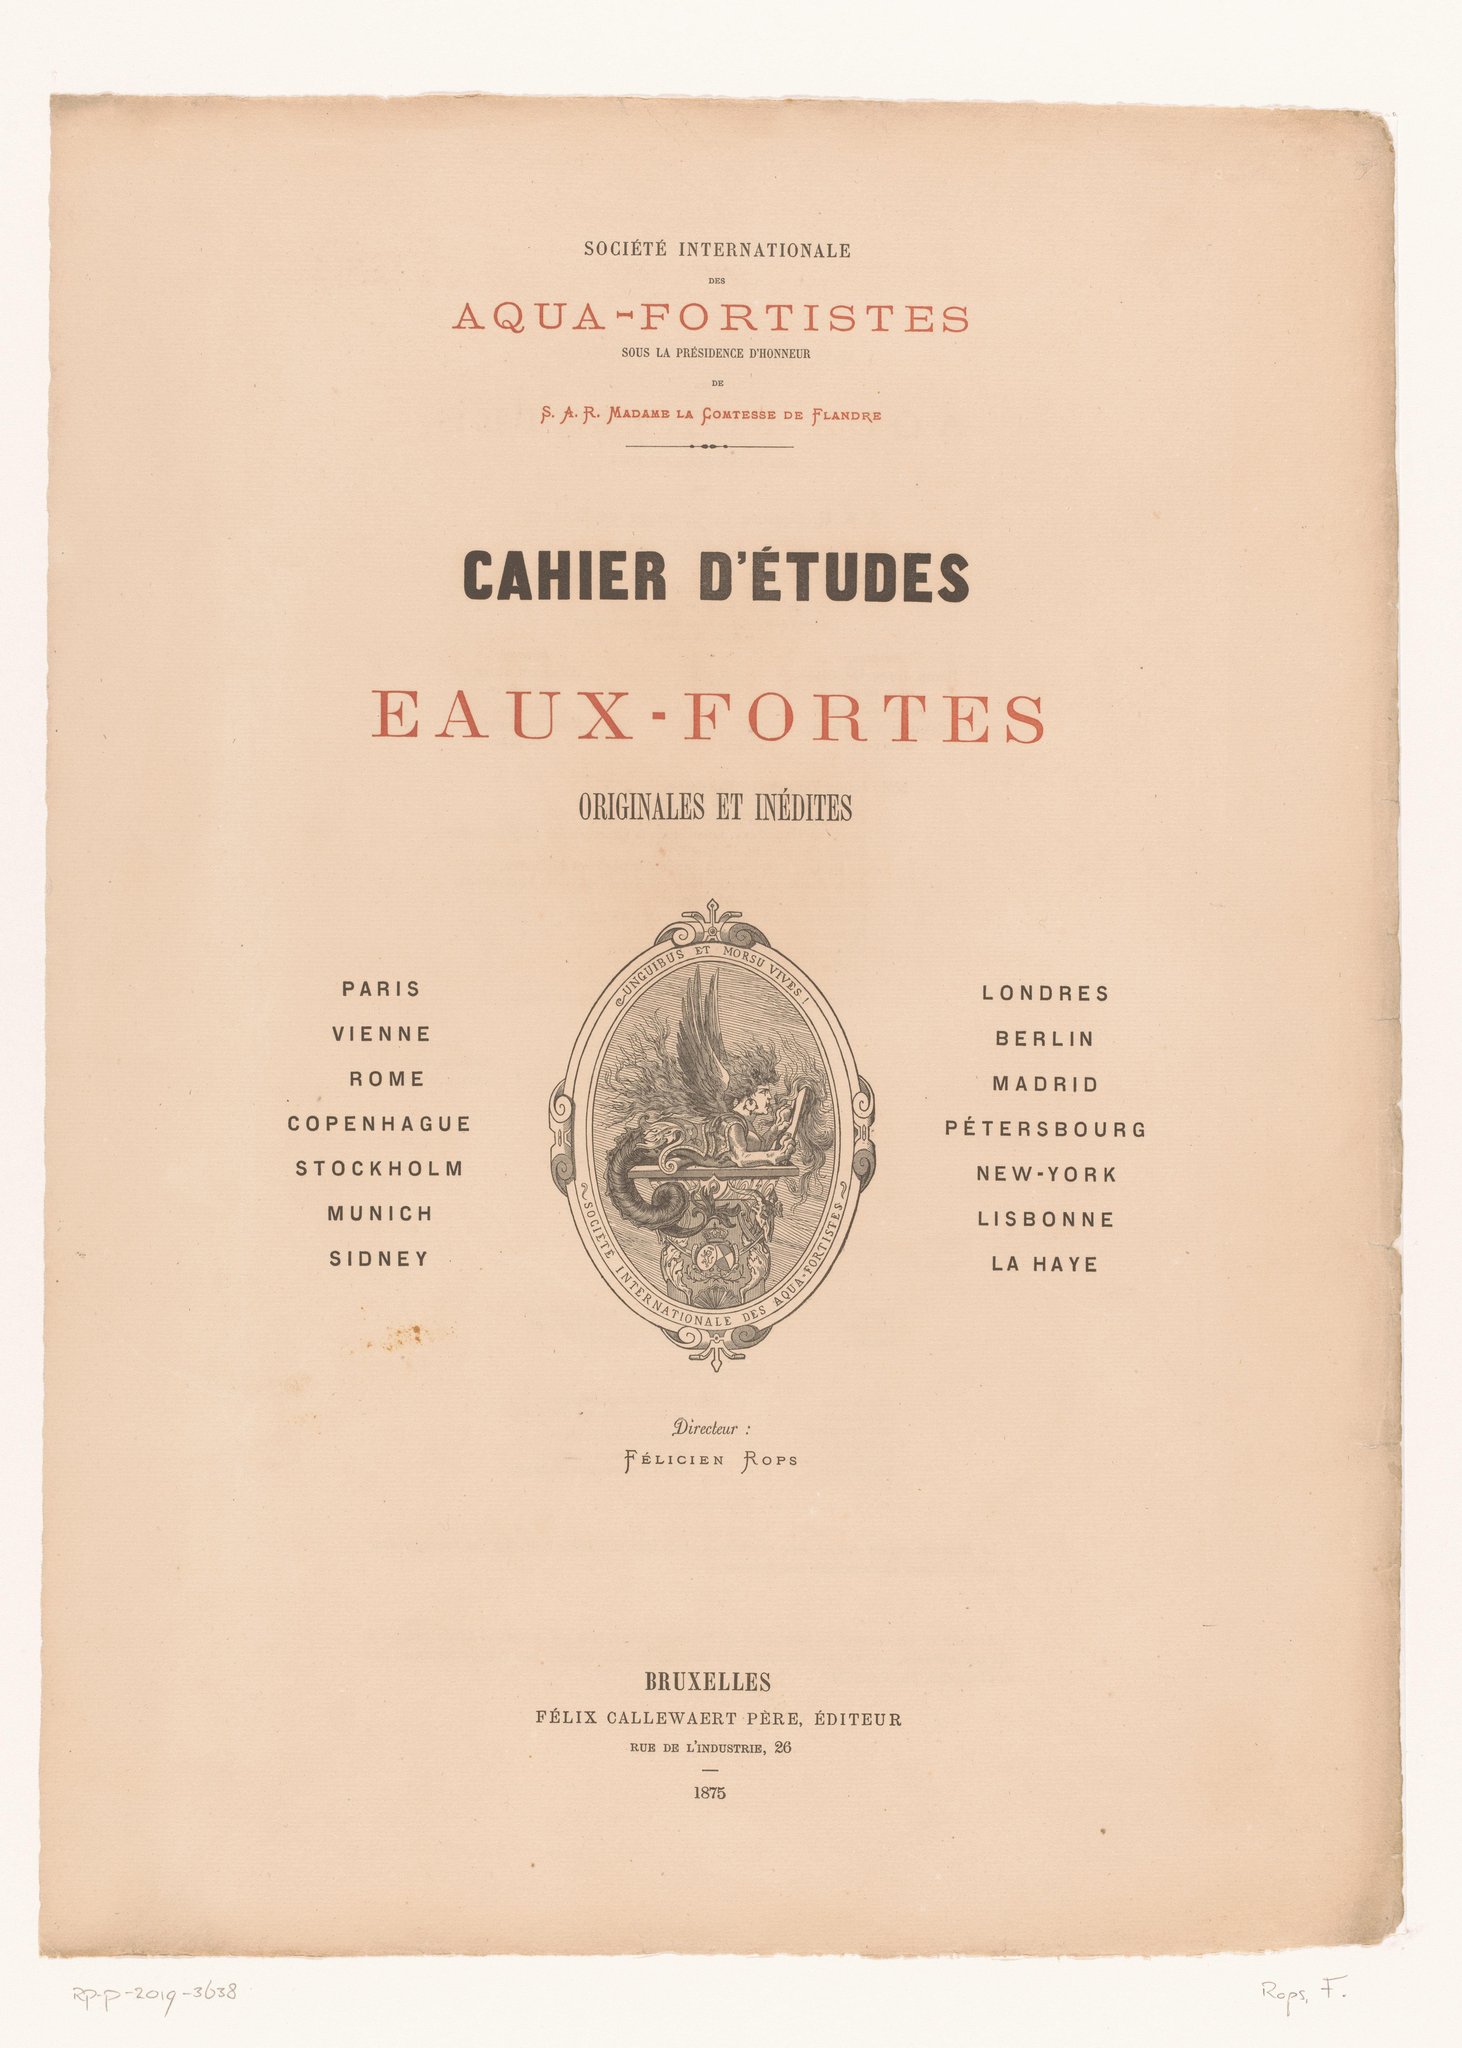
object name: photomechanical print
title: Titelpagina voor: Félicien Rops (red.), Cahier d'études eaux-fortes originales et inédites, 1875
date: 1875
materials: paper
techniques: letterpress printing, printing block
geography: brussels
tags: sphinx (lion/woman); 'sfinge' (ripa) - aa - female human figure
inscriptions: date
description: Geboorte- en sterfdatum van de prentmaker zijn onbekend. Daarom is voor de bepaling van de rechten van dit object gebruik gemaakt van de vervaardigingsdatum.